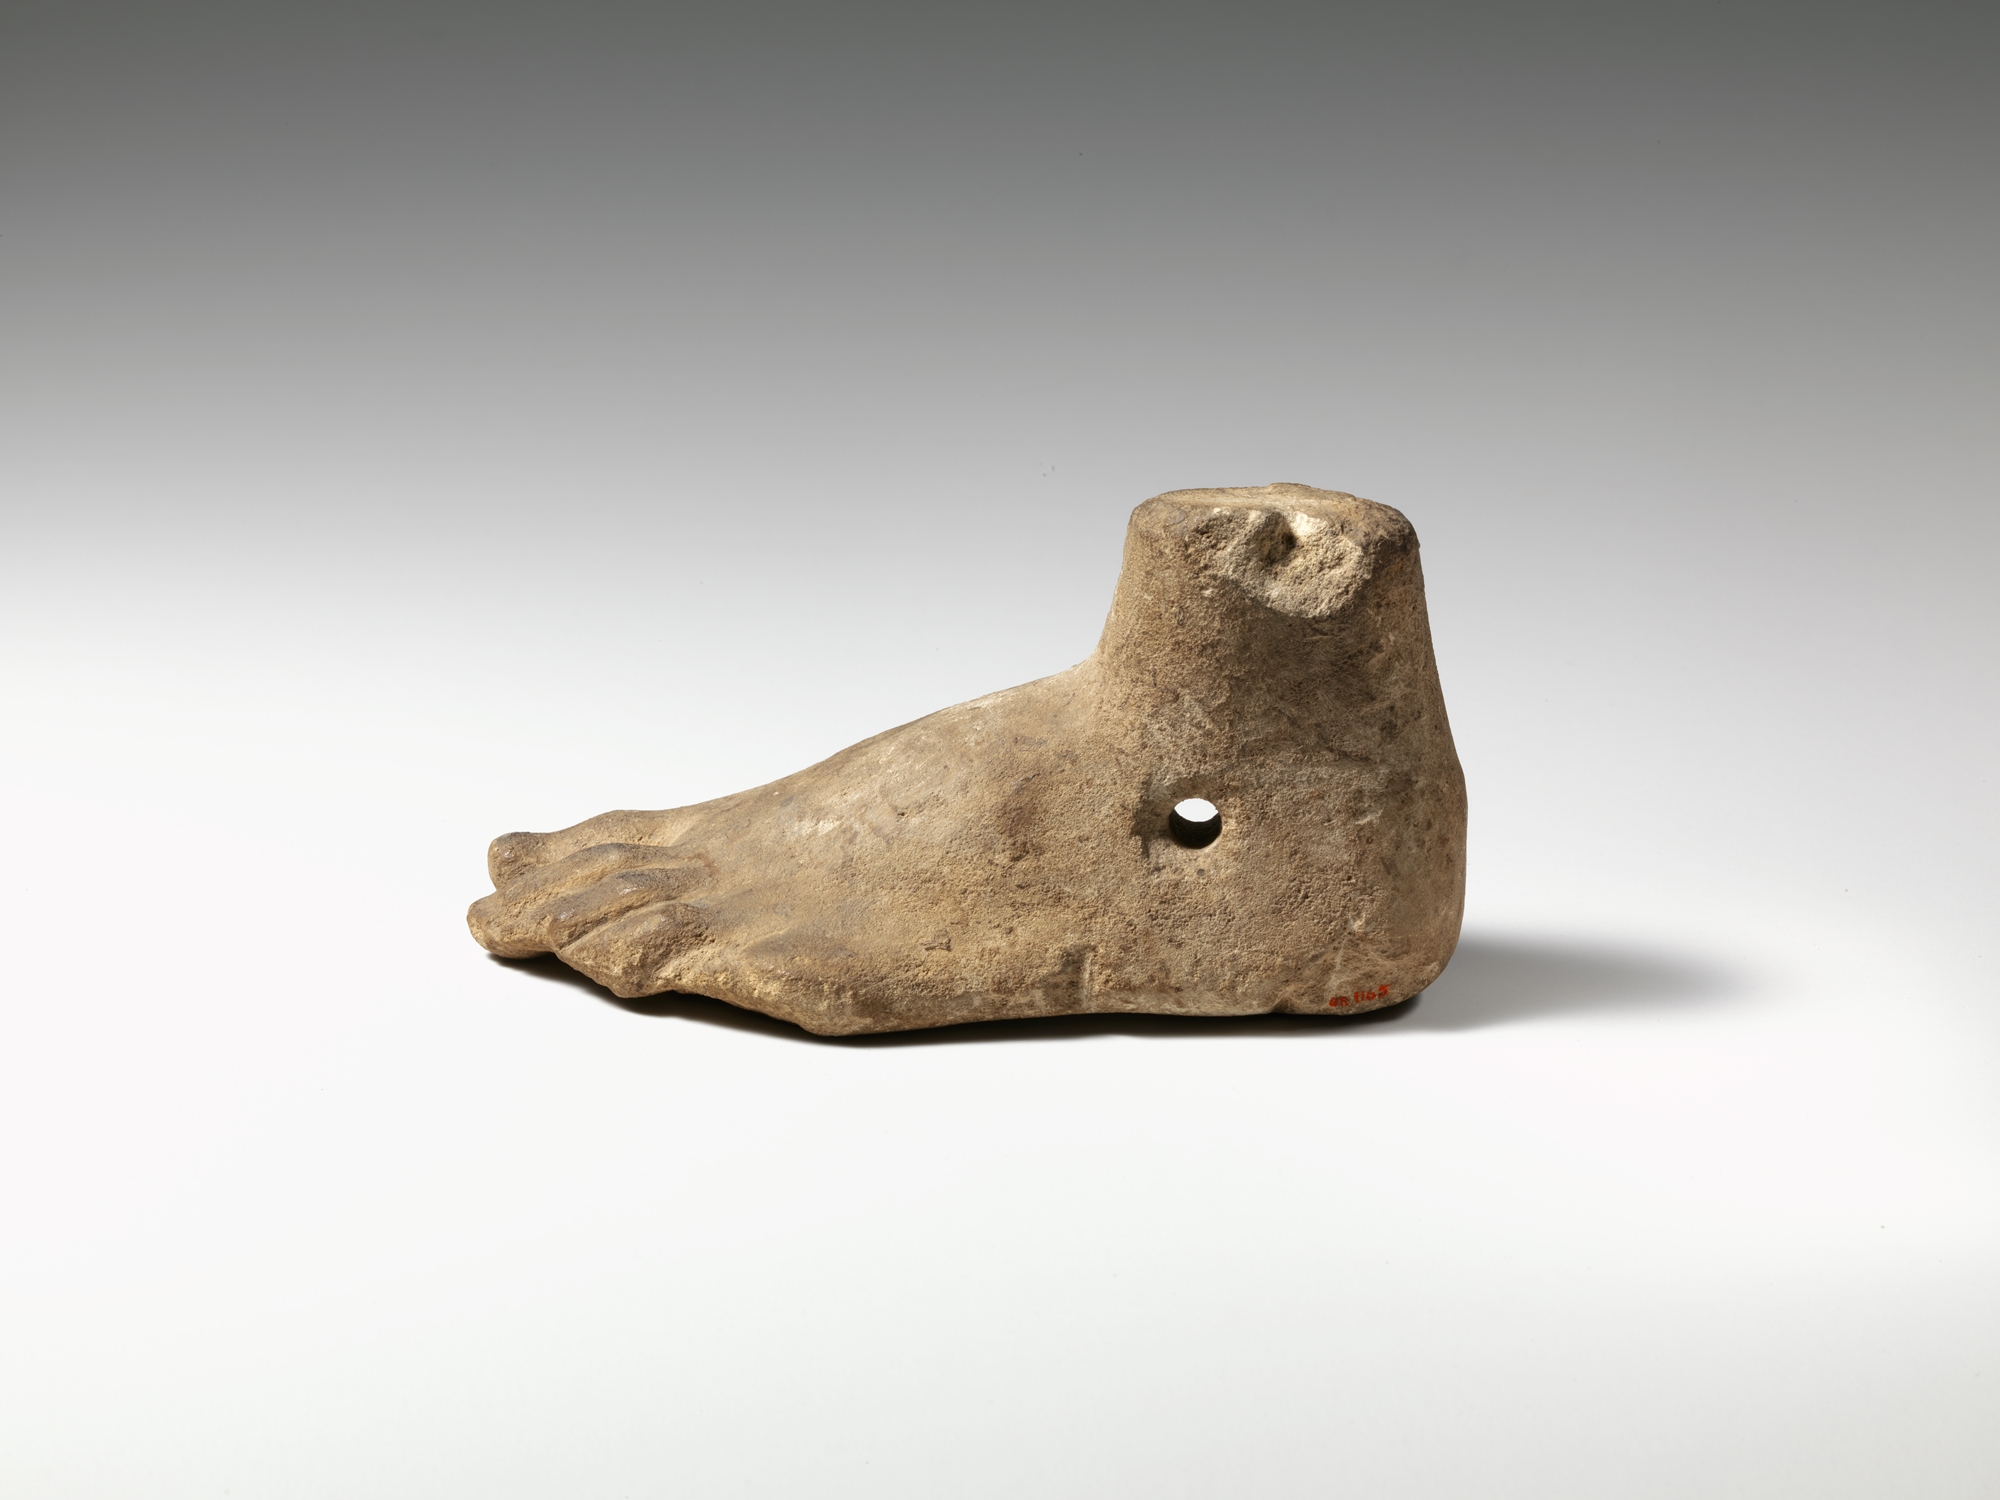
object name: foot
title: Limestone foot (left) with suspension hole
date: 670 BCE-330 CE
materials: limestone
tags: feet